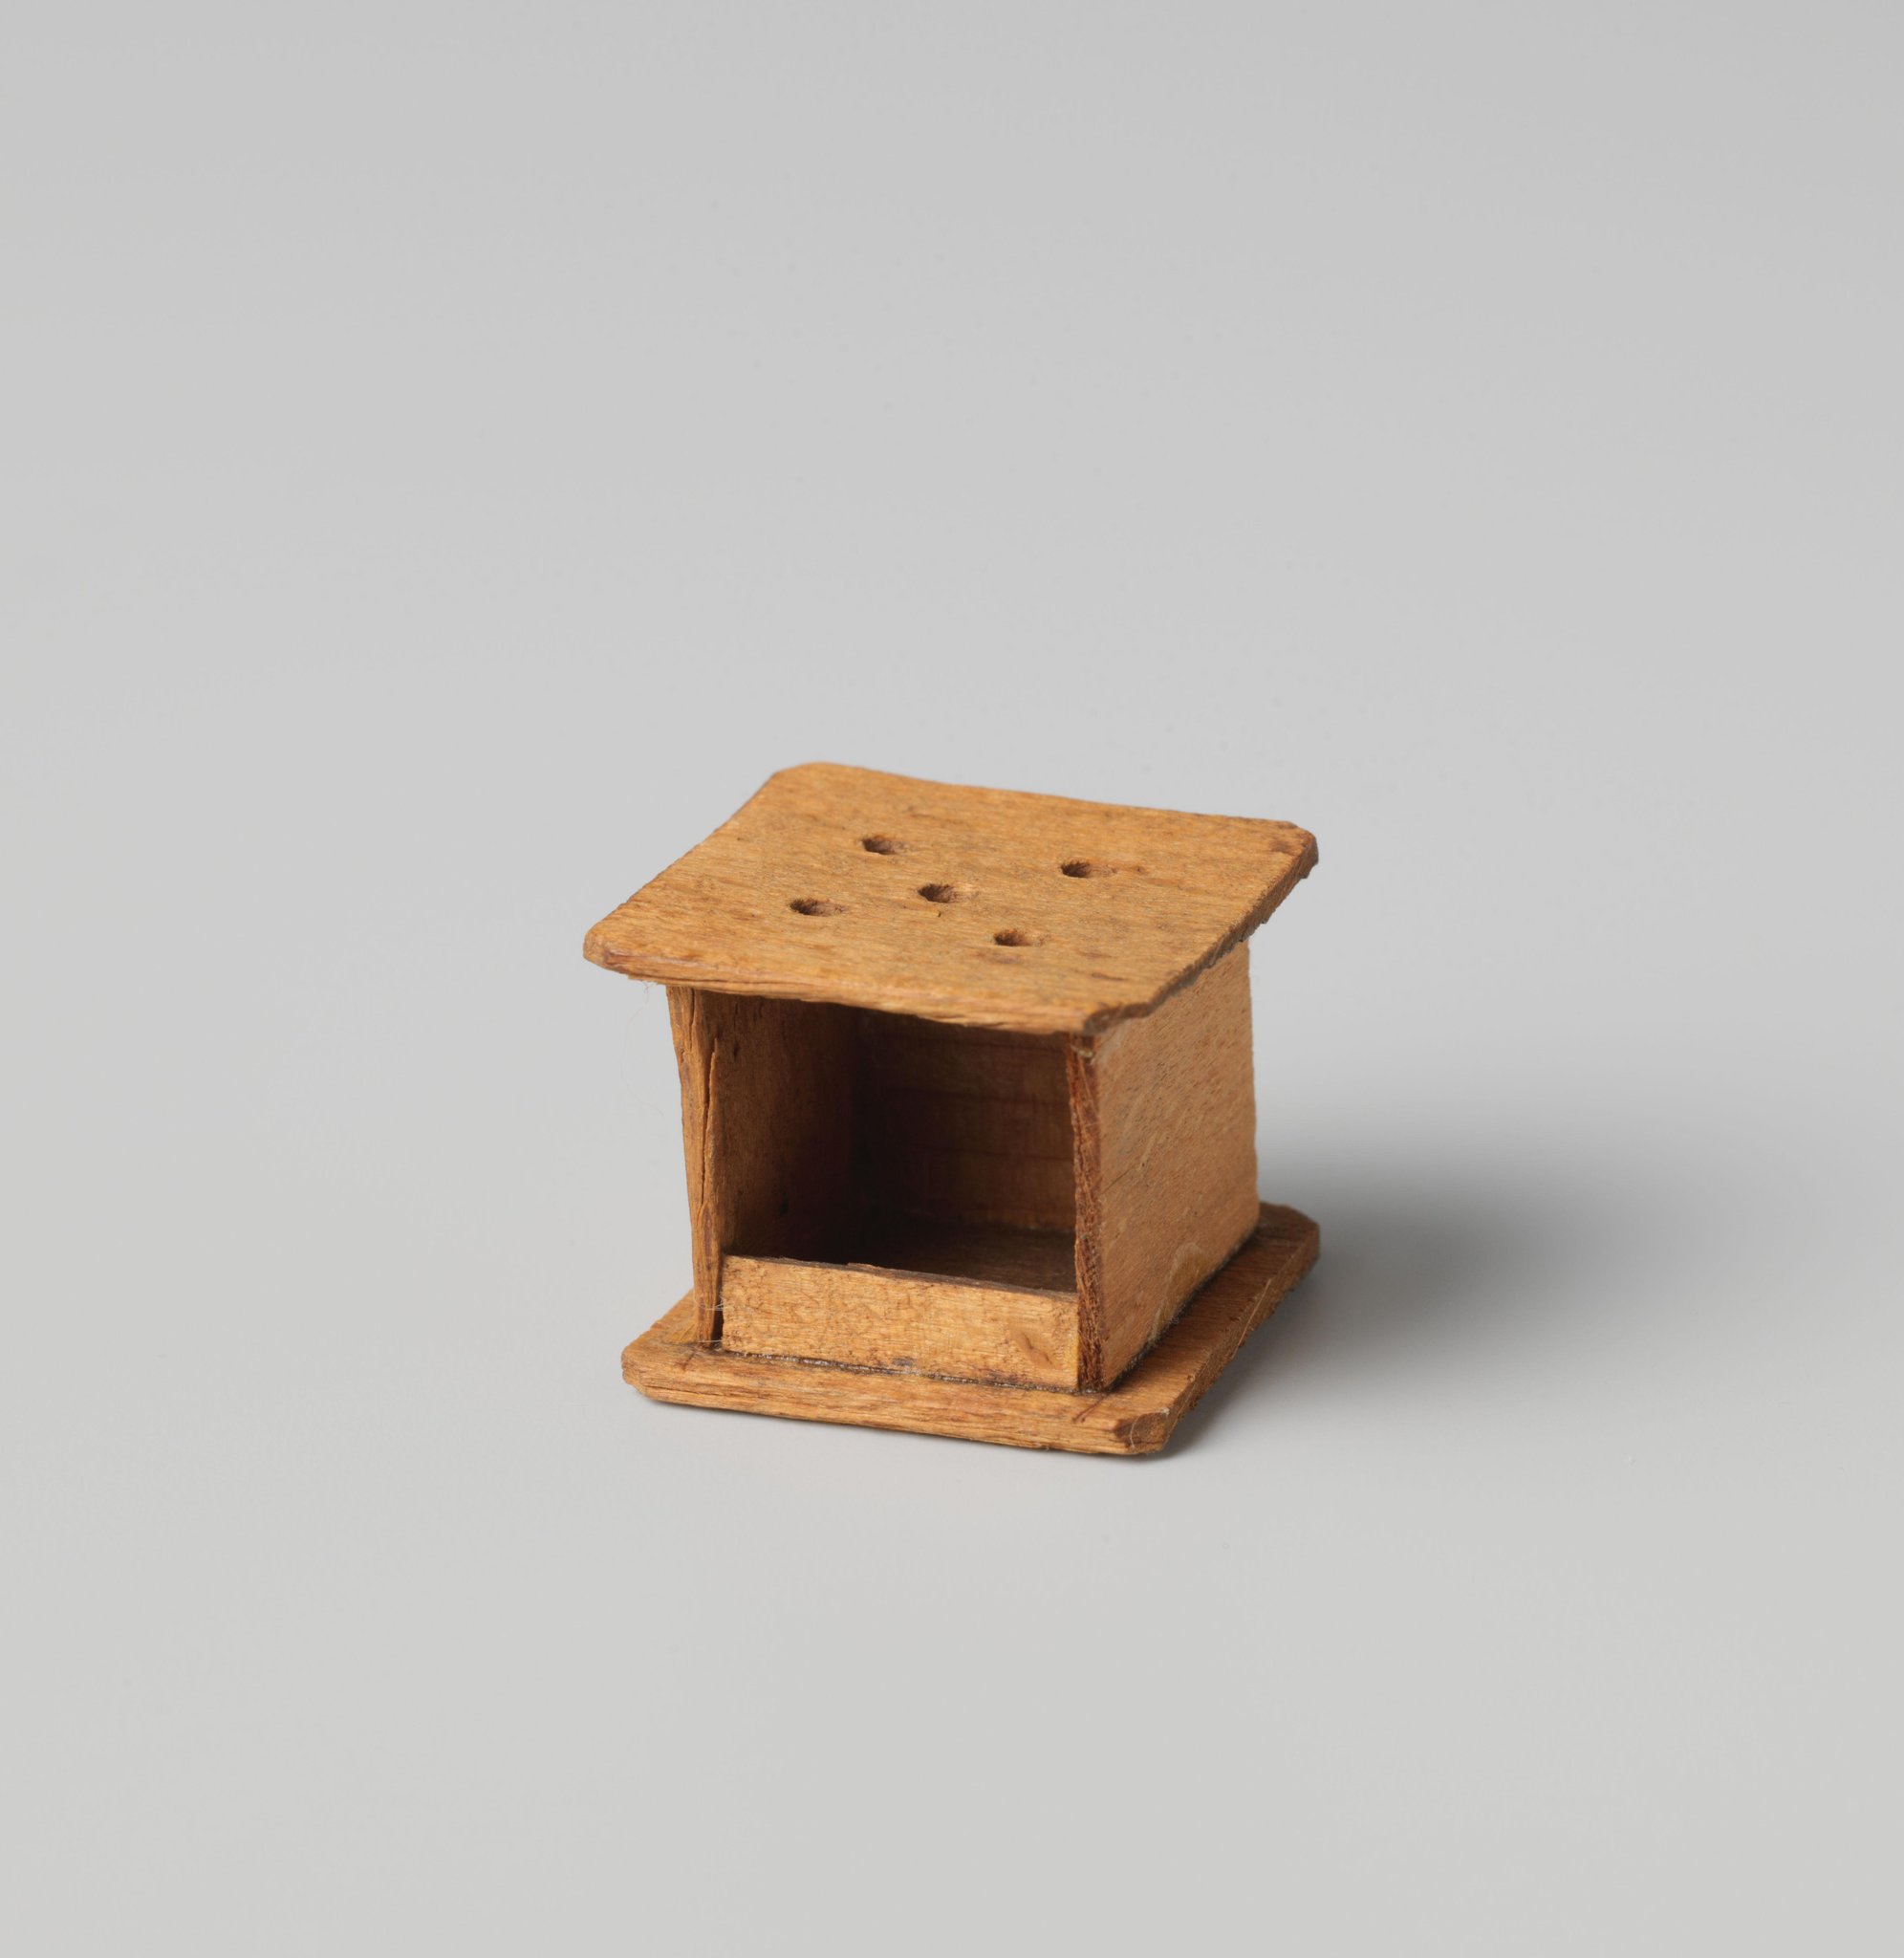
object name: miniature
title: Stoof, rechthoekig, met vijf gaten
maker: Anonymous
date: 1750-1800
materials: wood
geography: amsterdam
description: Stoof van beukenhout, rechthoekig, met vijf gaten in de bovenzijde; de achterzijde van grenenhout.